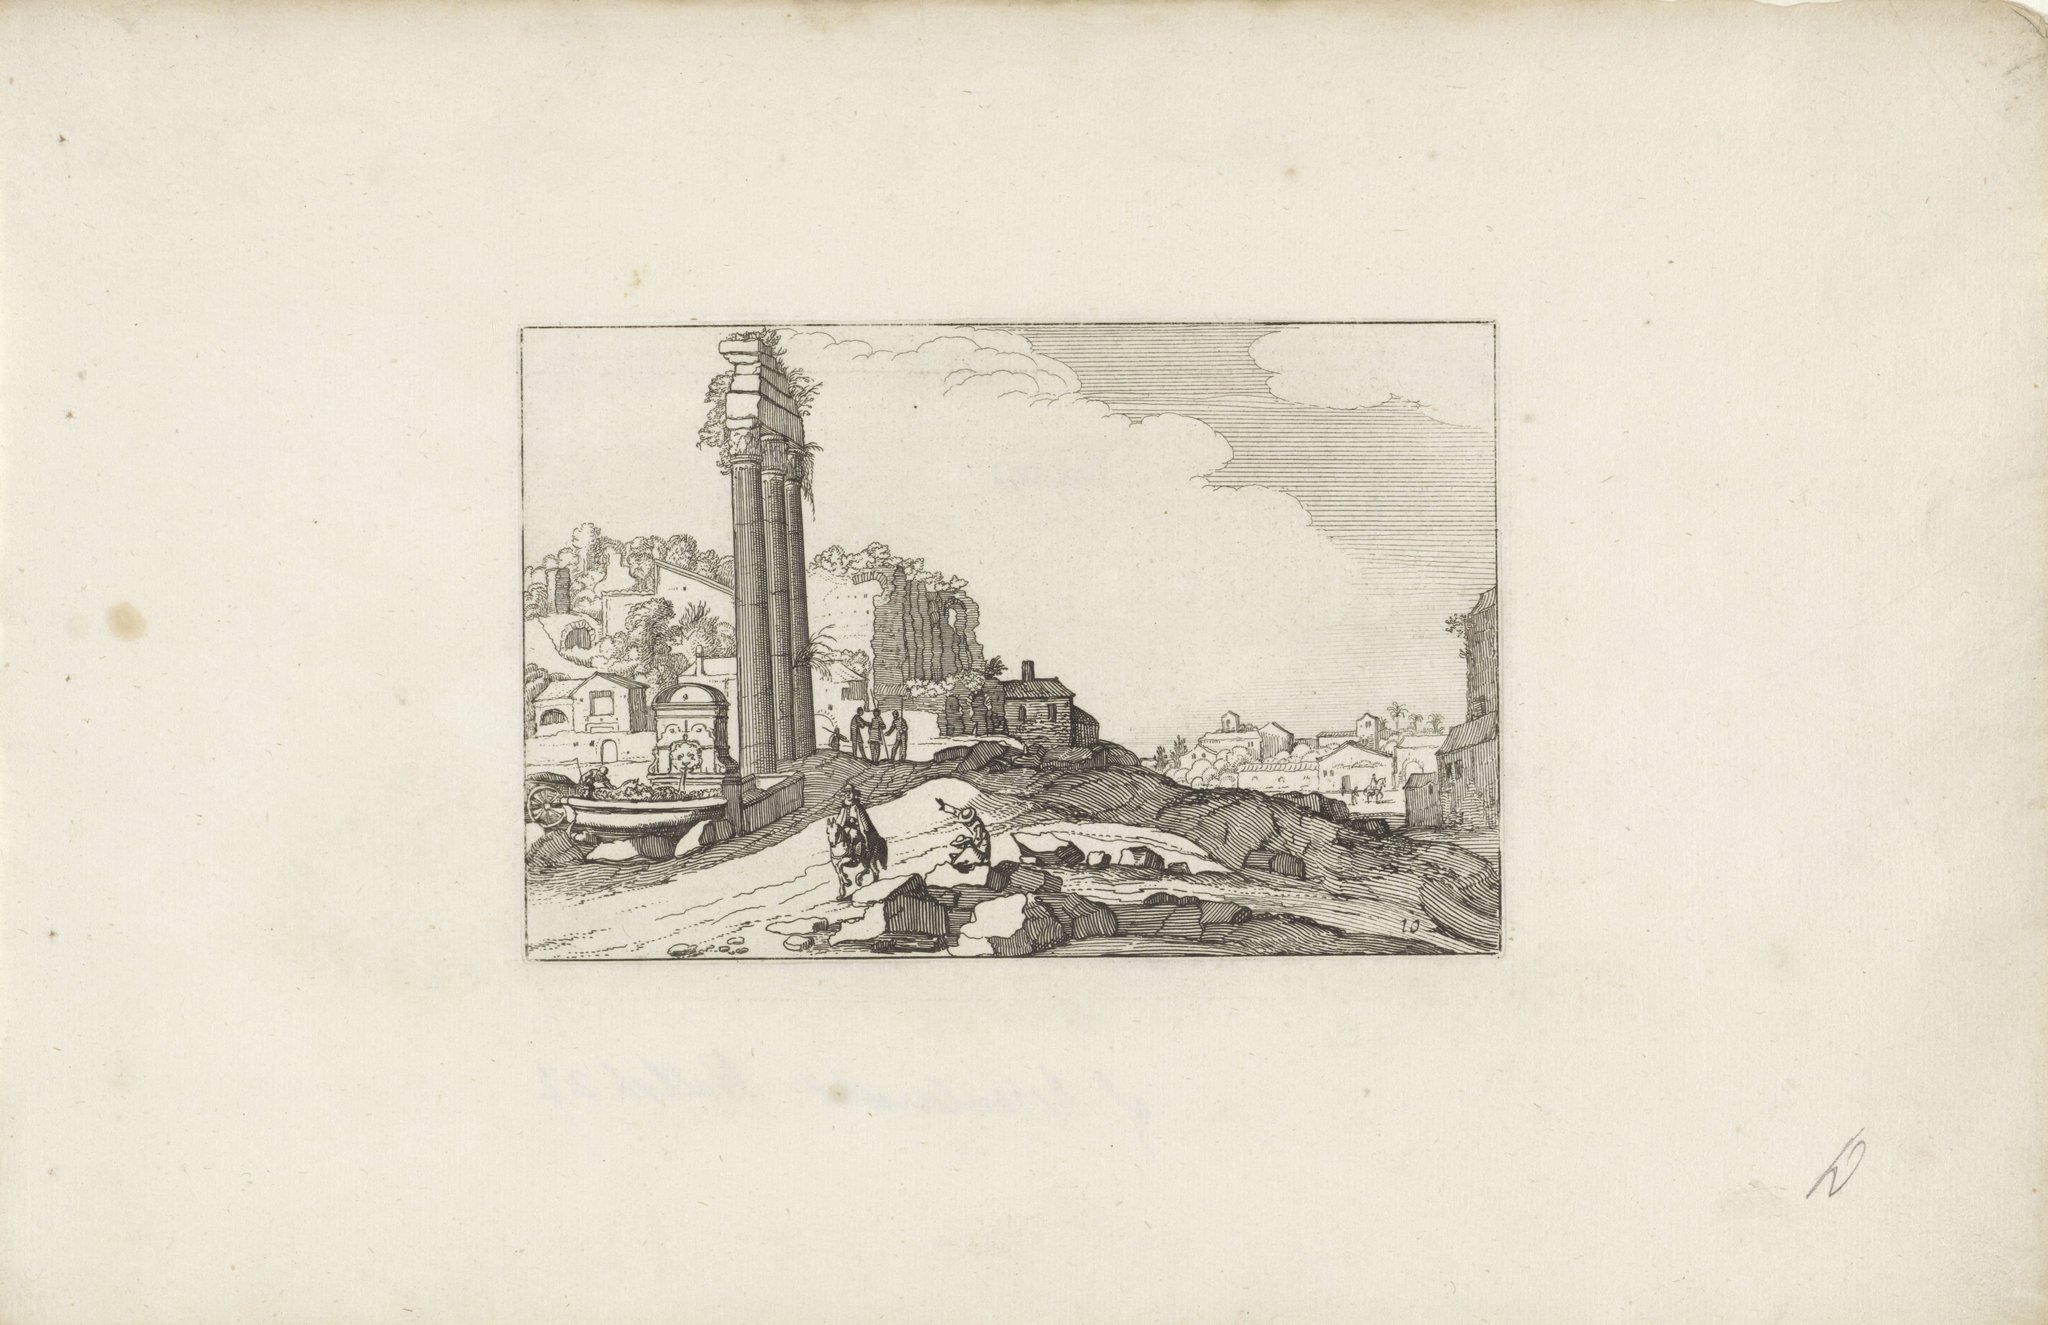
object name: print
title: Variae antiquitates Romanae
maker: claes jansz. visscher (ii)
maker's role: draughtsman, print maker, publisher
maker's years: 1586-1652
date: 1618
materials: paper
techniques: etching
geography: amsterdam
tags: riding a horse, ass, or mule; rider, horseman, landscape with ruins, index finger forwards, pointing, indicating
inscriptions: collector's mark: Lugt 2233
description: Gezicht op de ruïne van de tempel van Castor en Pollux te Rome. Bij de ruïne bevinden zich enkele figuren, waarvan er een naar de tempel wijst.